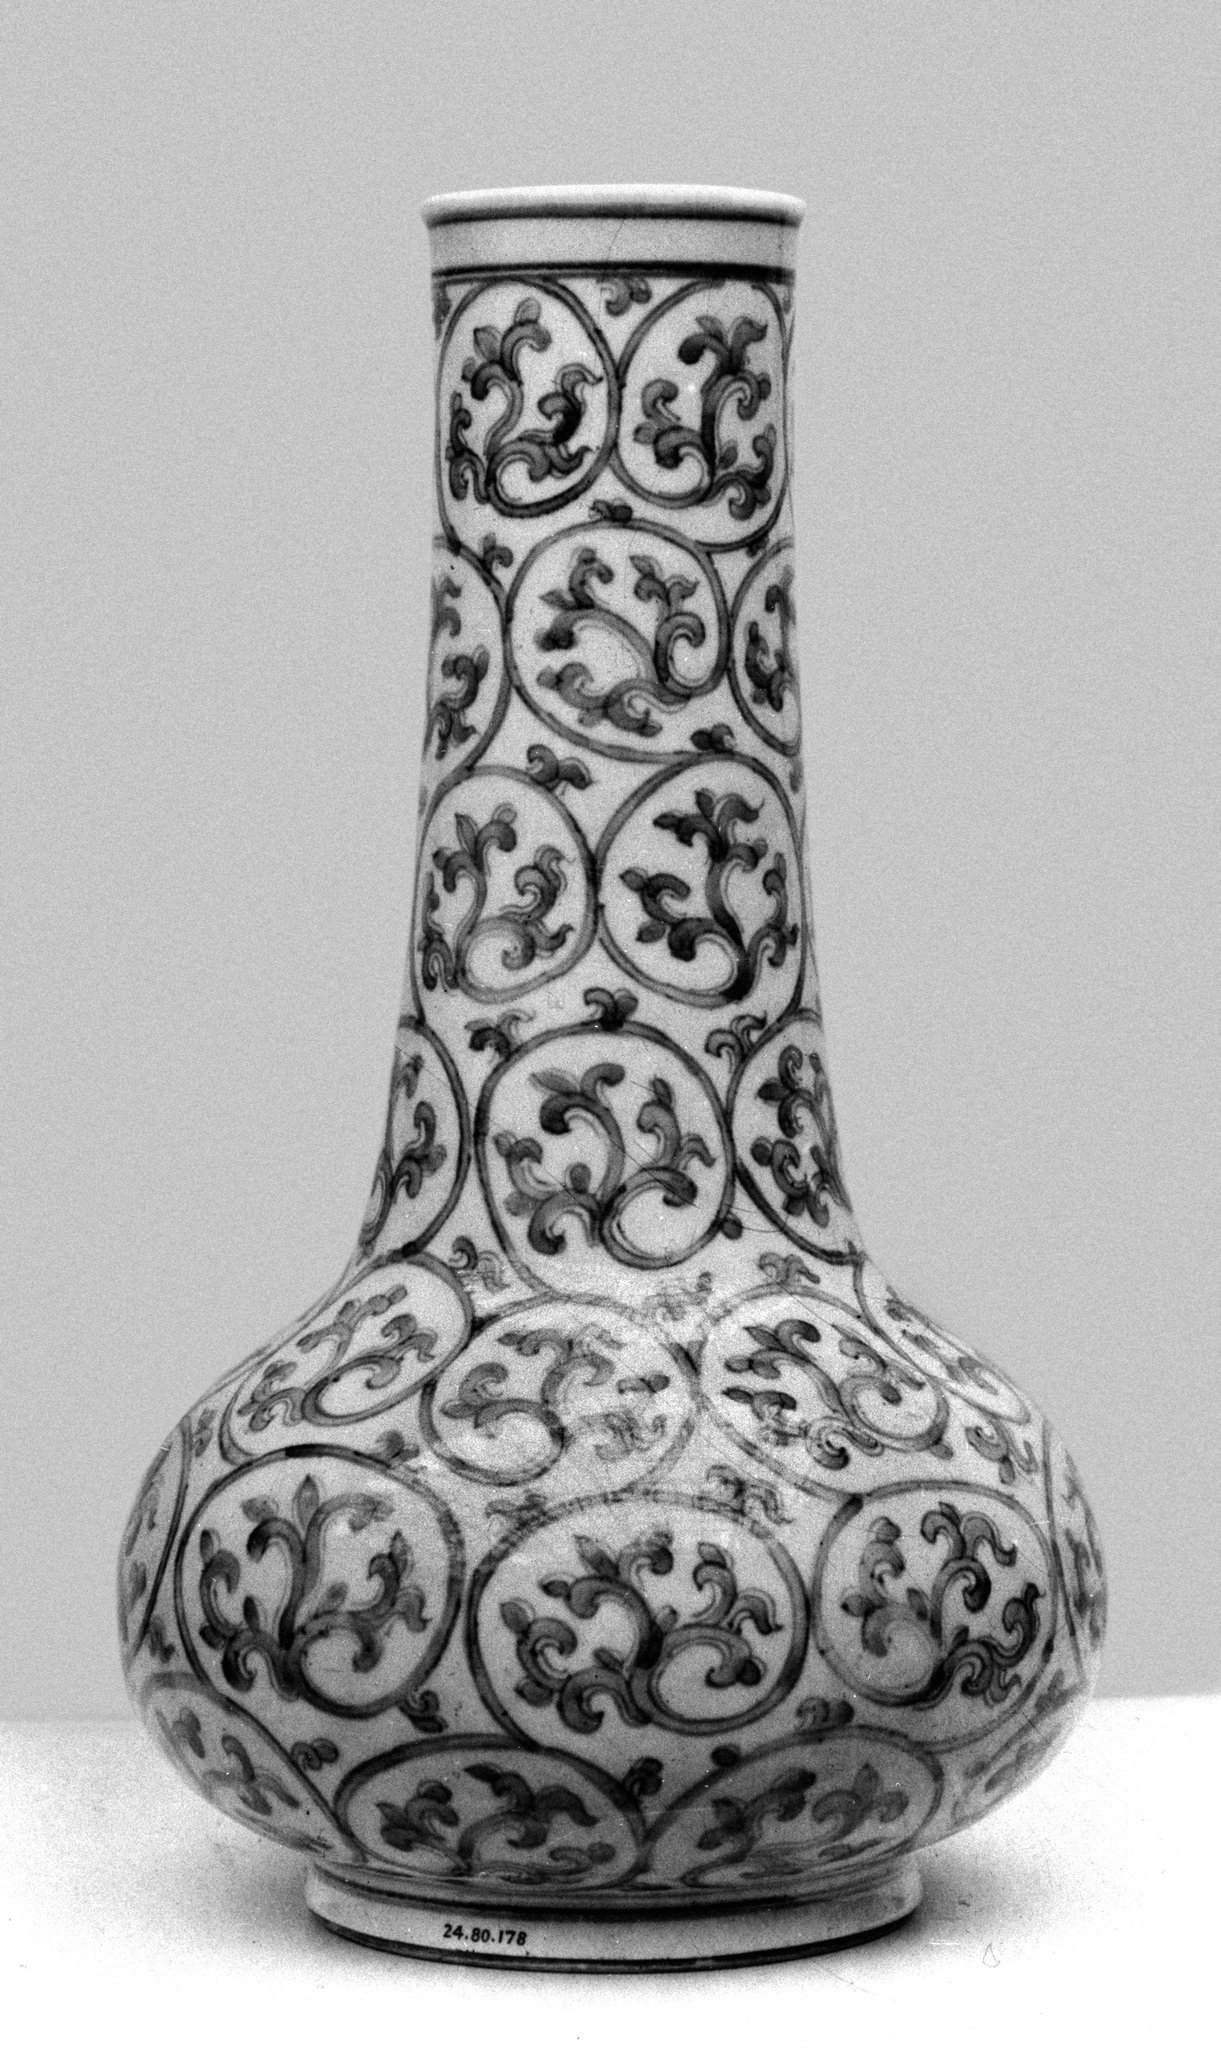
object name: bottle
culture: chinese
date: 1368-1644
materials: porcelain